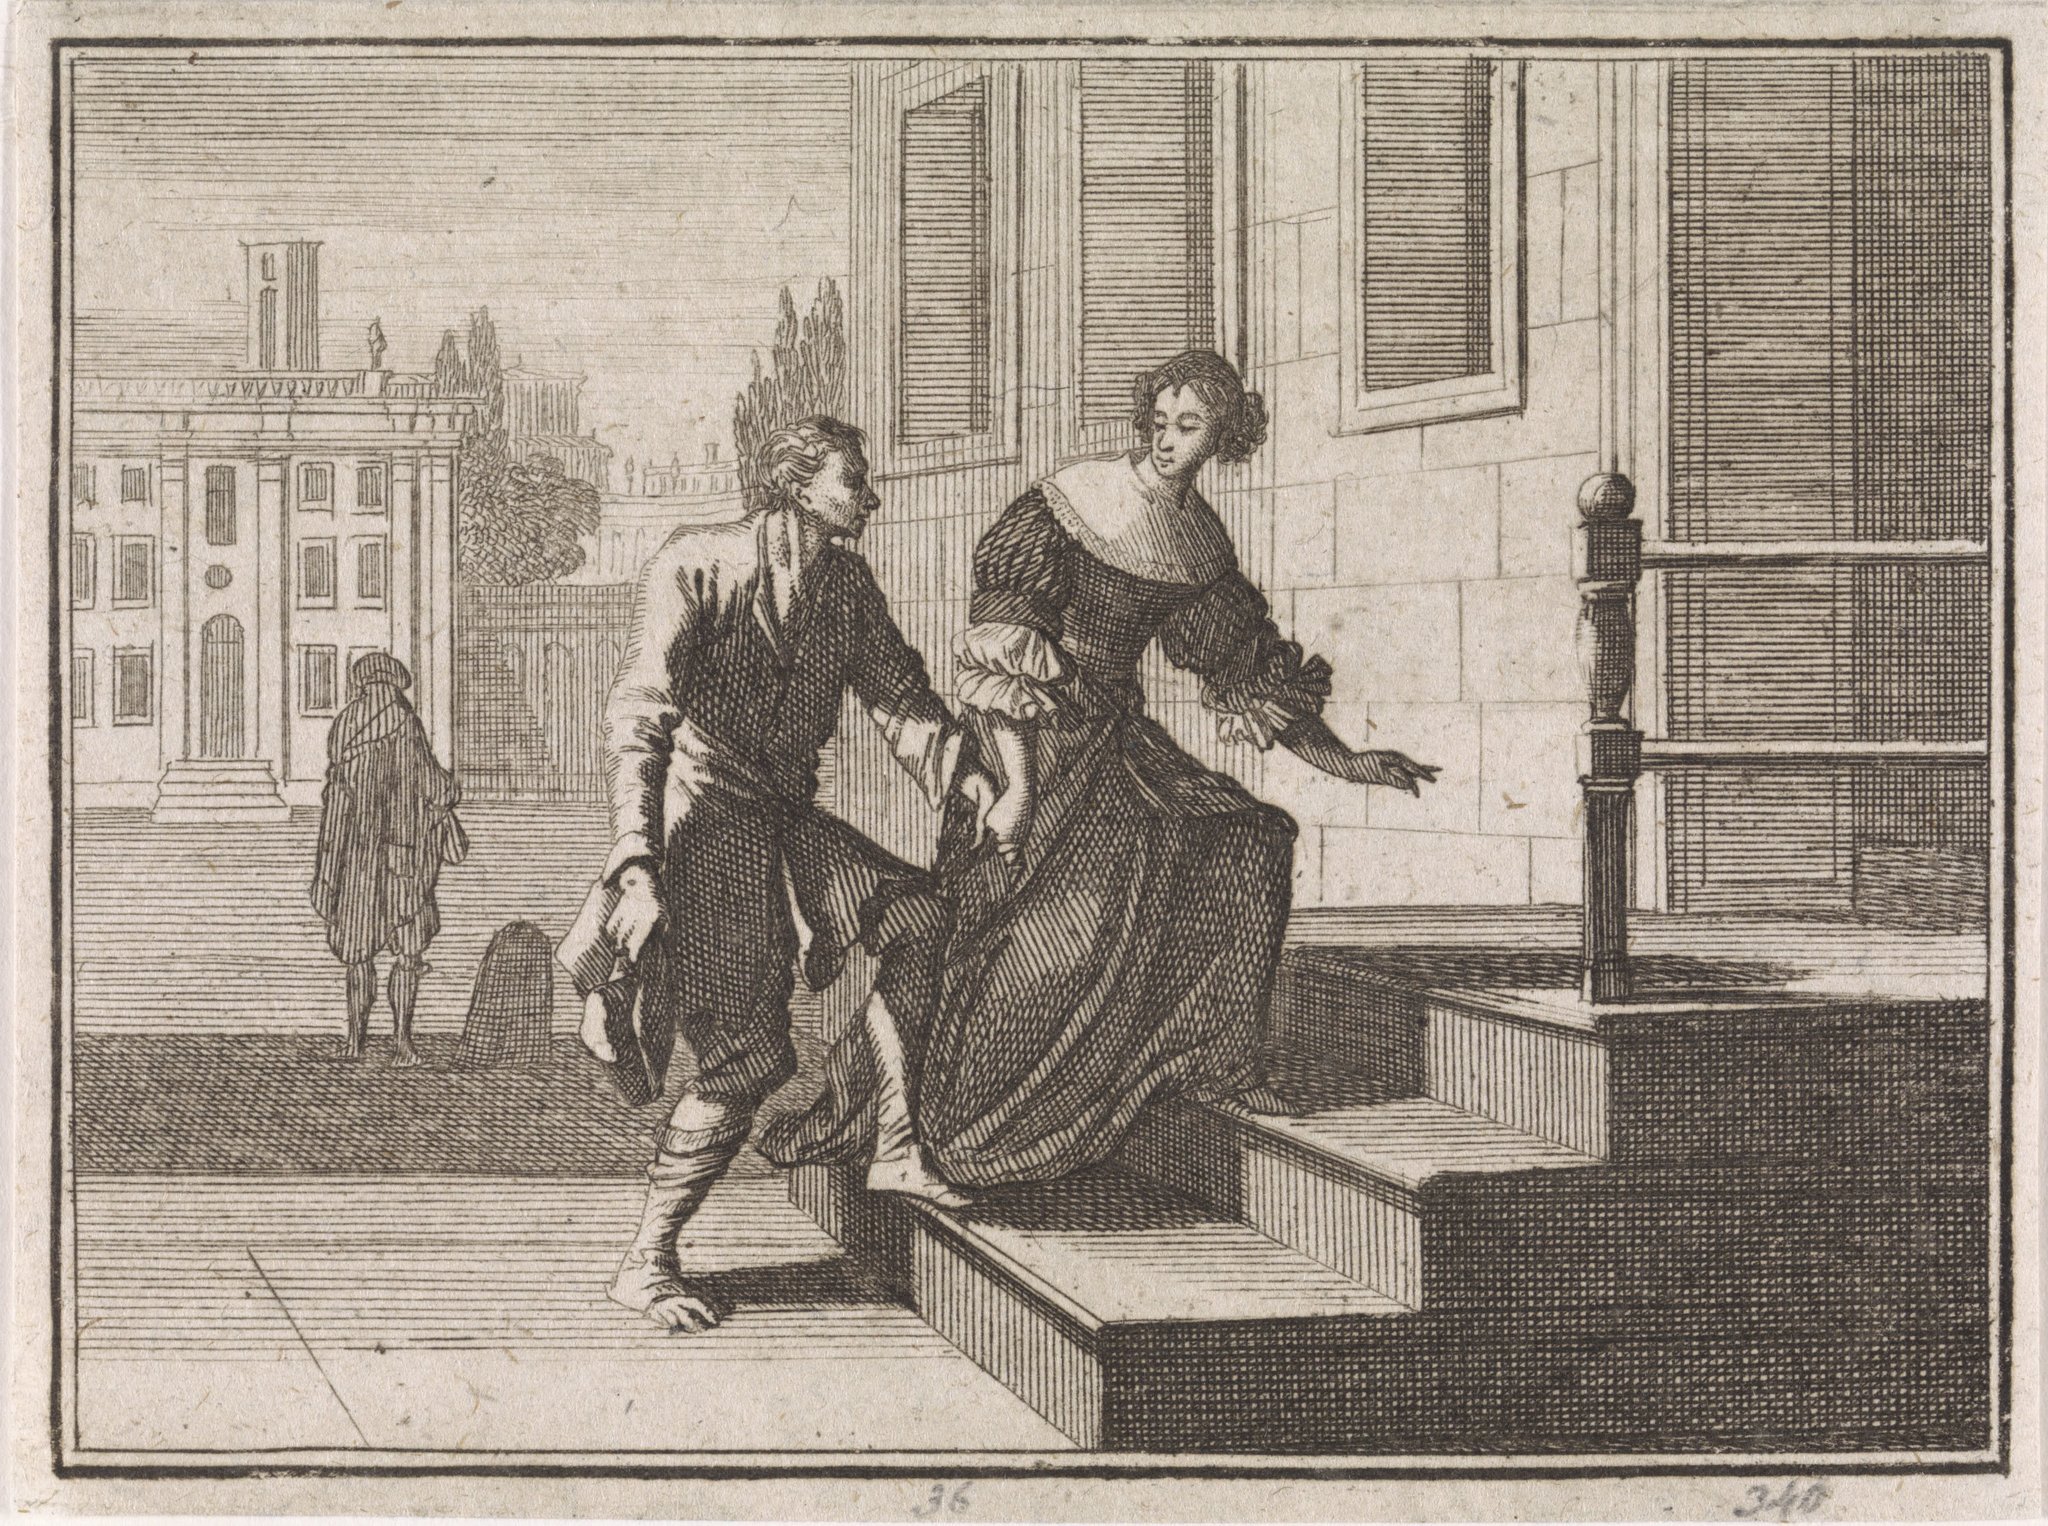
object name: book illustration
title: Der erlaubte Zigeuner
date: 1704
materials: paper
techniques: etching, letterpress printing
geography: nuremberg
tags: contrast between rich and poor, wandering communities: romani or roma, front steps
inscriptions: collector's mark: Lugt 2228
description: Illustratie uit: Abraham a Sancta Clara. Heilsames Gemisch Gemasch, das ist: Allerley seltsame und verwunderliche Geschichten (...). Neurenberg: Christoph Weigel, 1704, p. 340.